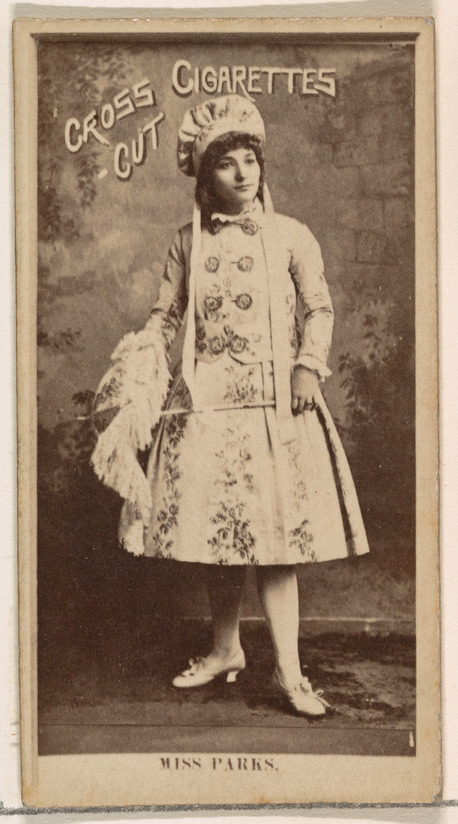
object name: print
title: Miss Parks, from the Actors and Actresses series (N145-2) issued by Duke Sons & Co. to promote Cross Cut Cigarettes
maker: w. duke, sons & co.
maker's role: publisher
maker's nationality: american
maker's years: 1870-1920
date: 1880-1889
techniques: albumen silver print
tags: portraits,women,actresses